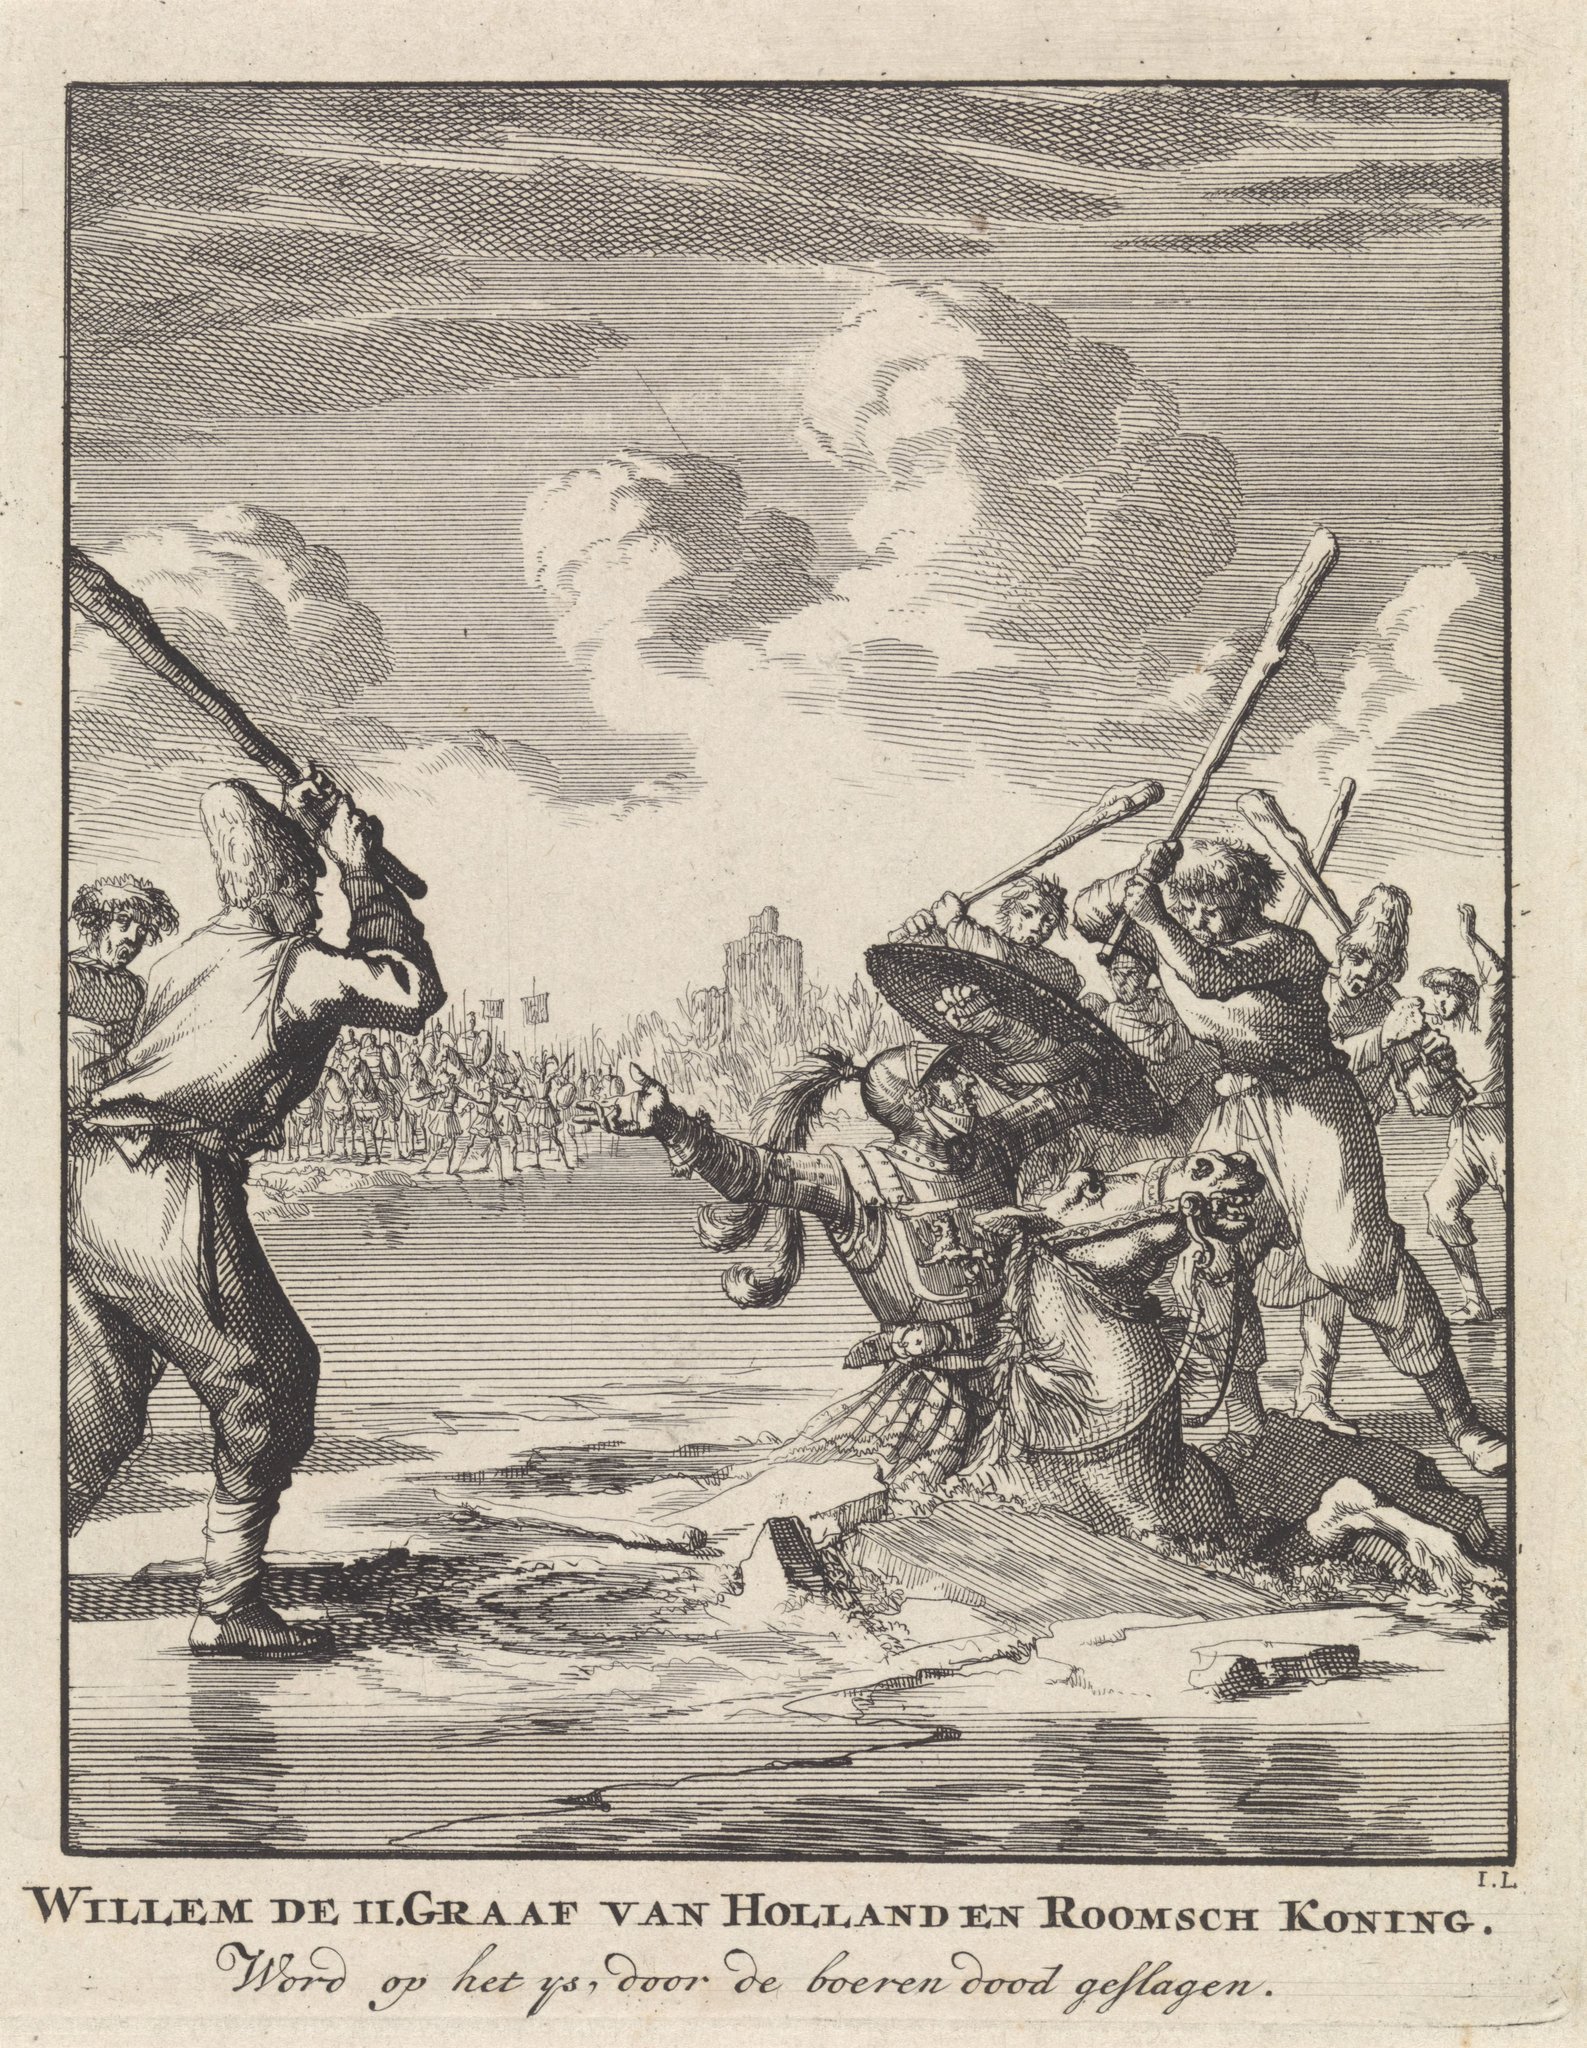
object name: print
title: Willem de II Graaf van Holland en Roomsch Koning, Word ophet ys, door de boeren dood geslagen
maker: jan luyken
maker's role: draughtsman, print maker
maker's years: 1649-1712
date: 1698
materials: paper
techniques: etching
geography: amsterdam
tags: earl, violent death, being killed; being mishandled and maltreated; seeking death, attempt, political murder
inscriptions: collector's mark: Lugt 2228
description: Proefdruk van illustratie uit: Bos, Lambert van den. Treur-toonneel der doorluchtige mannen, of Op- en ondergang der grooten, 3 delen. Amsterdam: Jan Claesz ten Hoorn, 1698, dl. I.